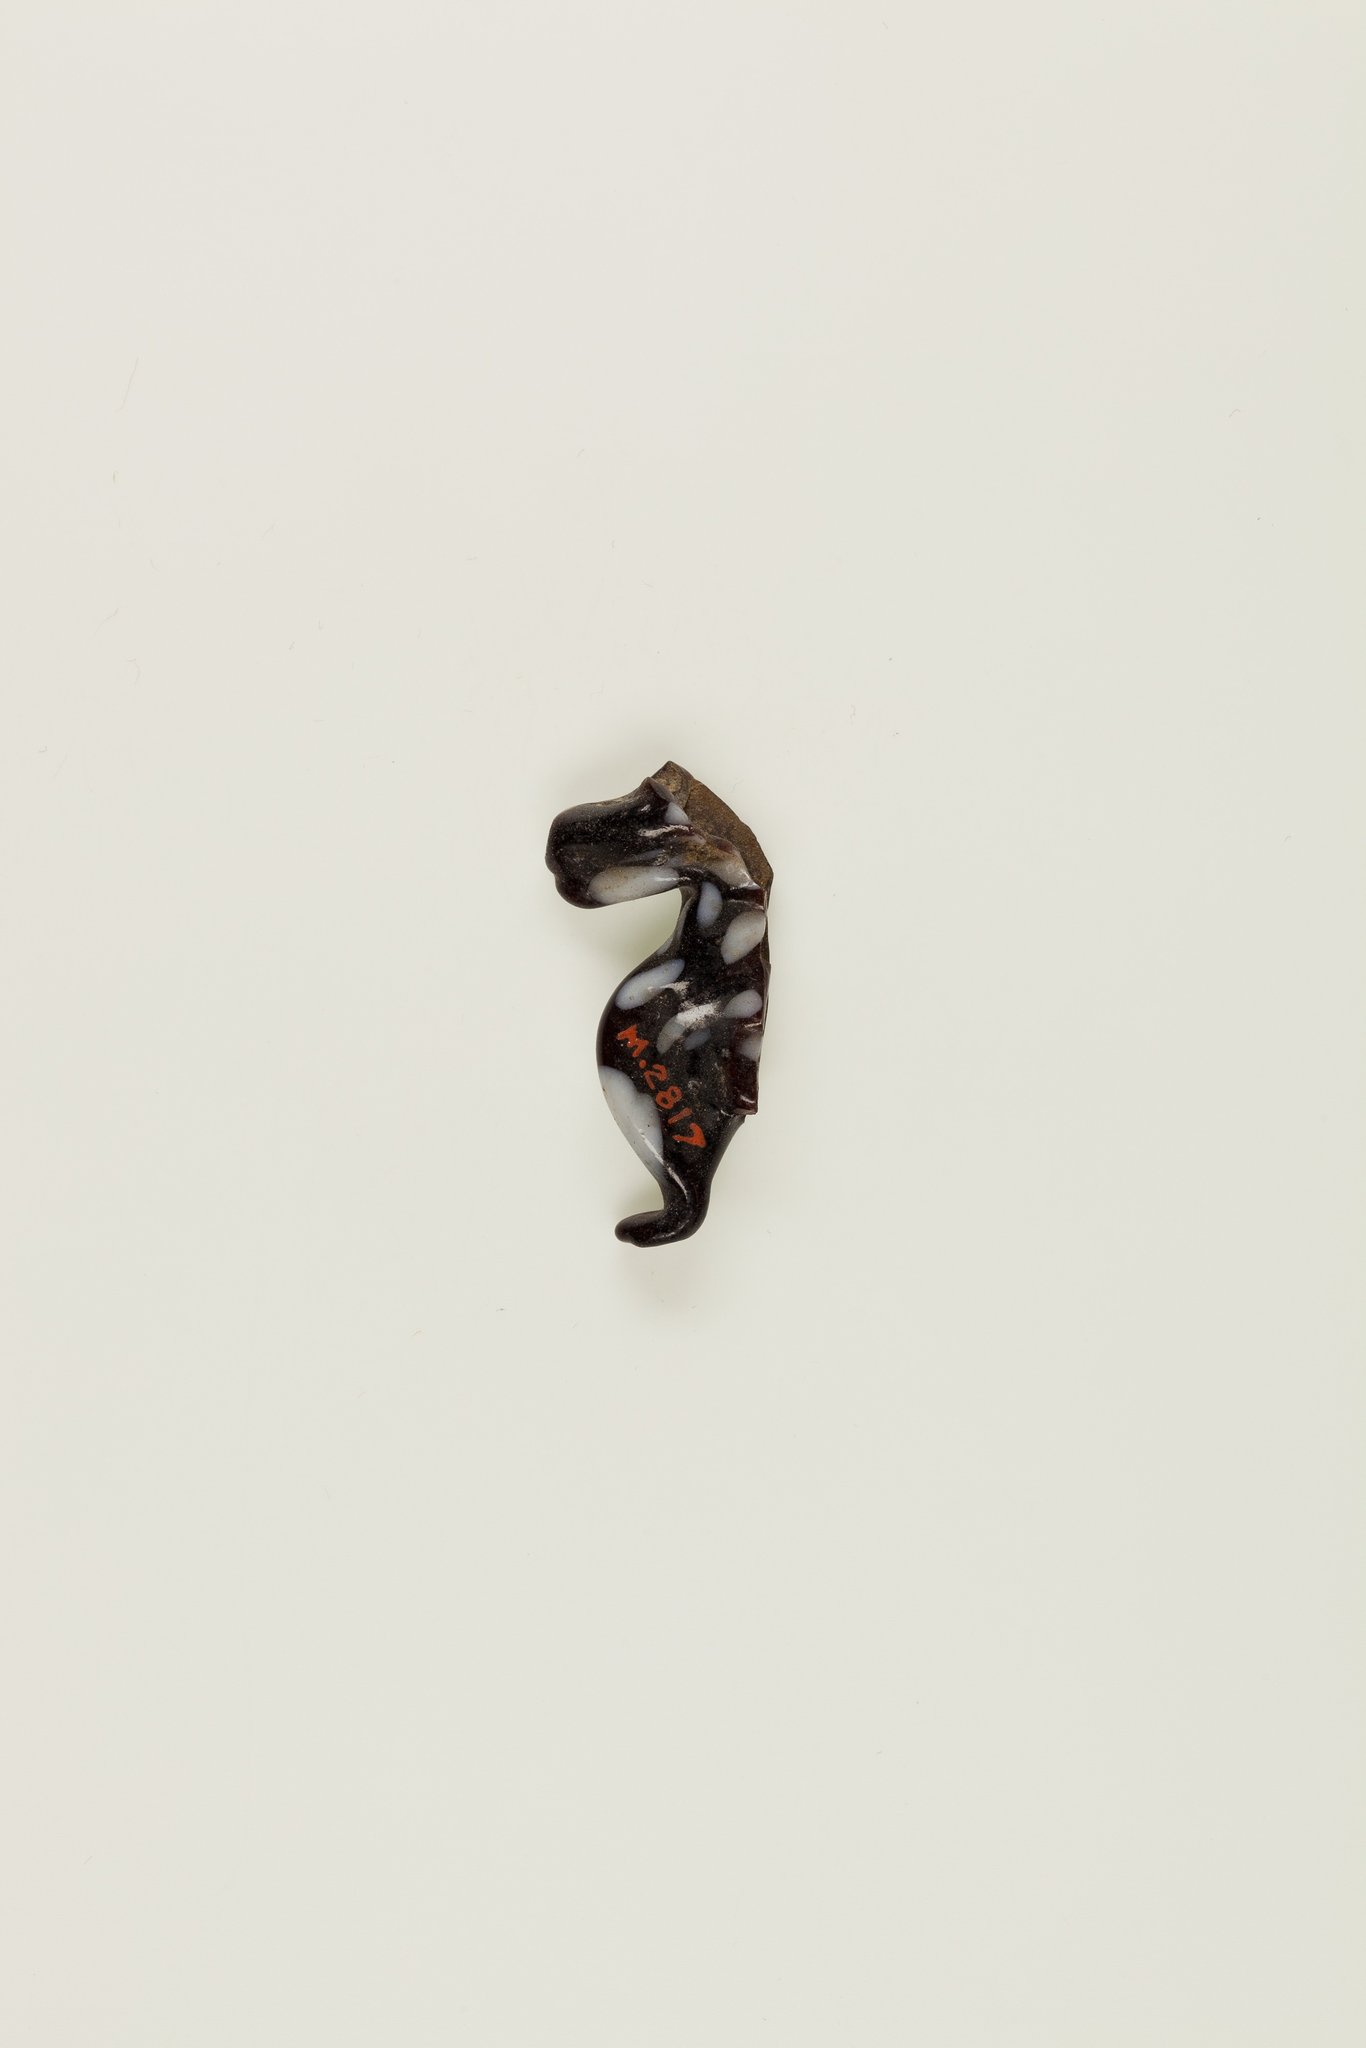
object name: amulet, taweret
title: Taweret amulet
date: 100 BCE-100 CE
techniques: mosaic glass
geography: egypt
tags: taweret